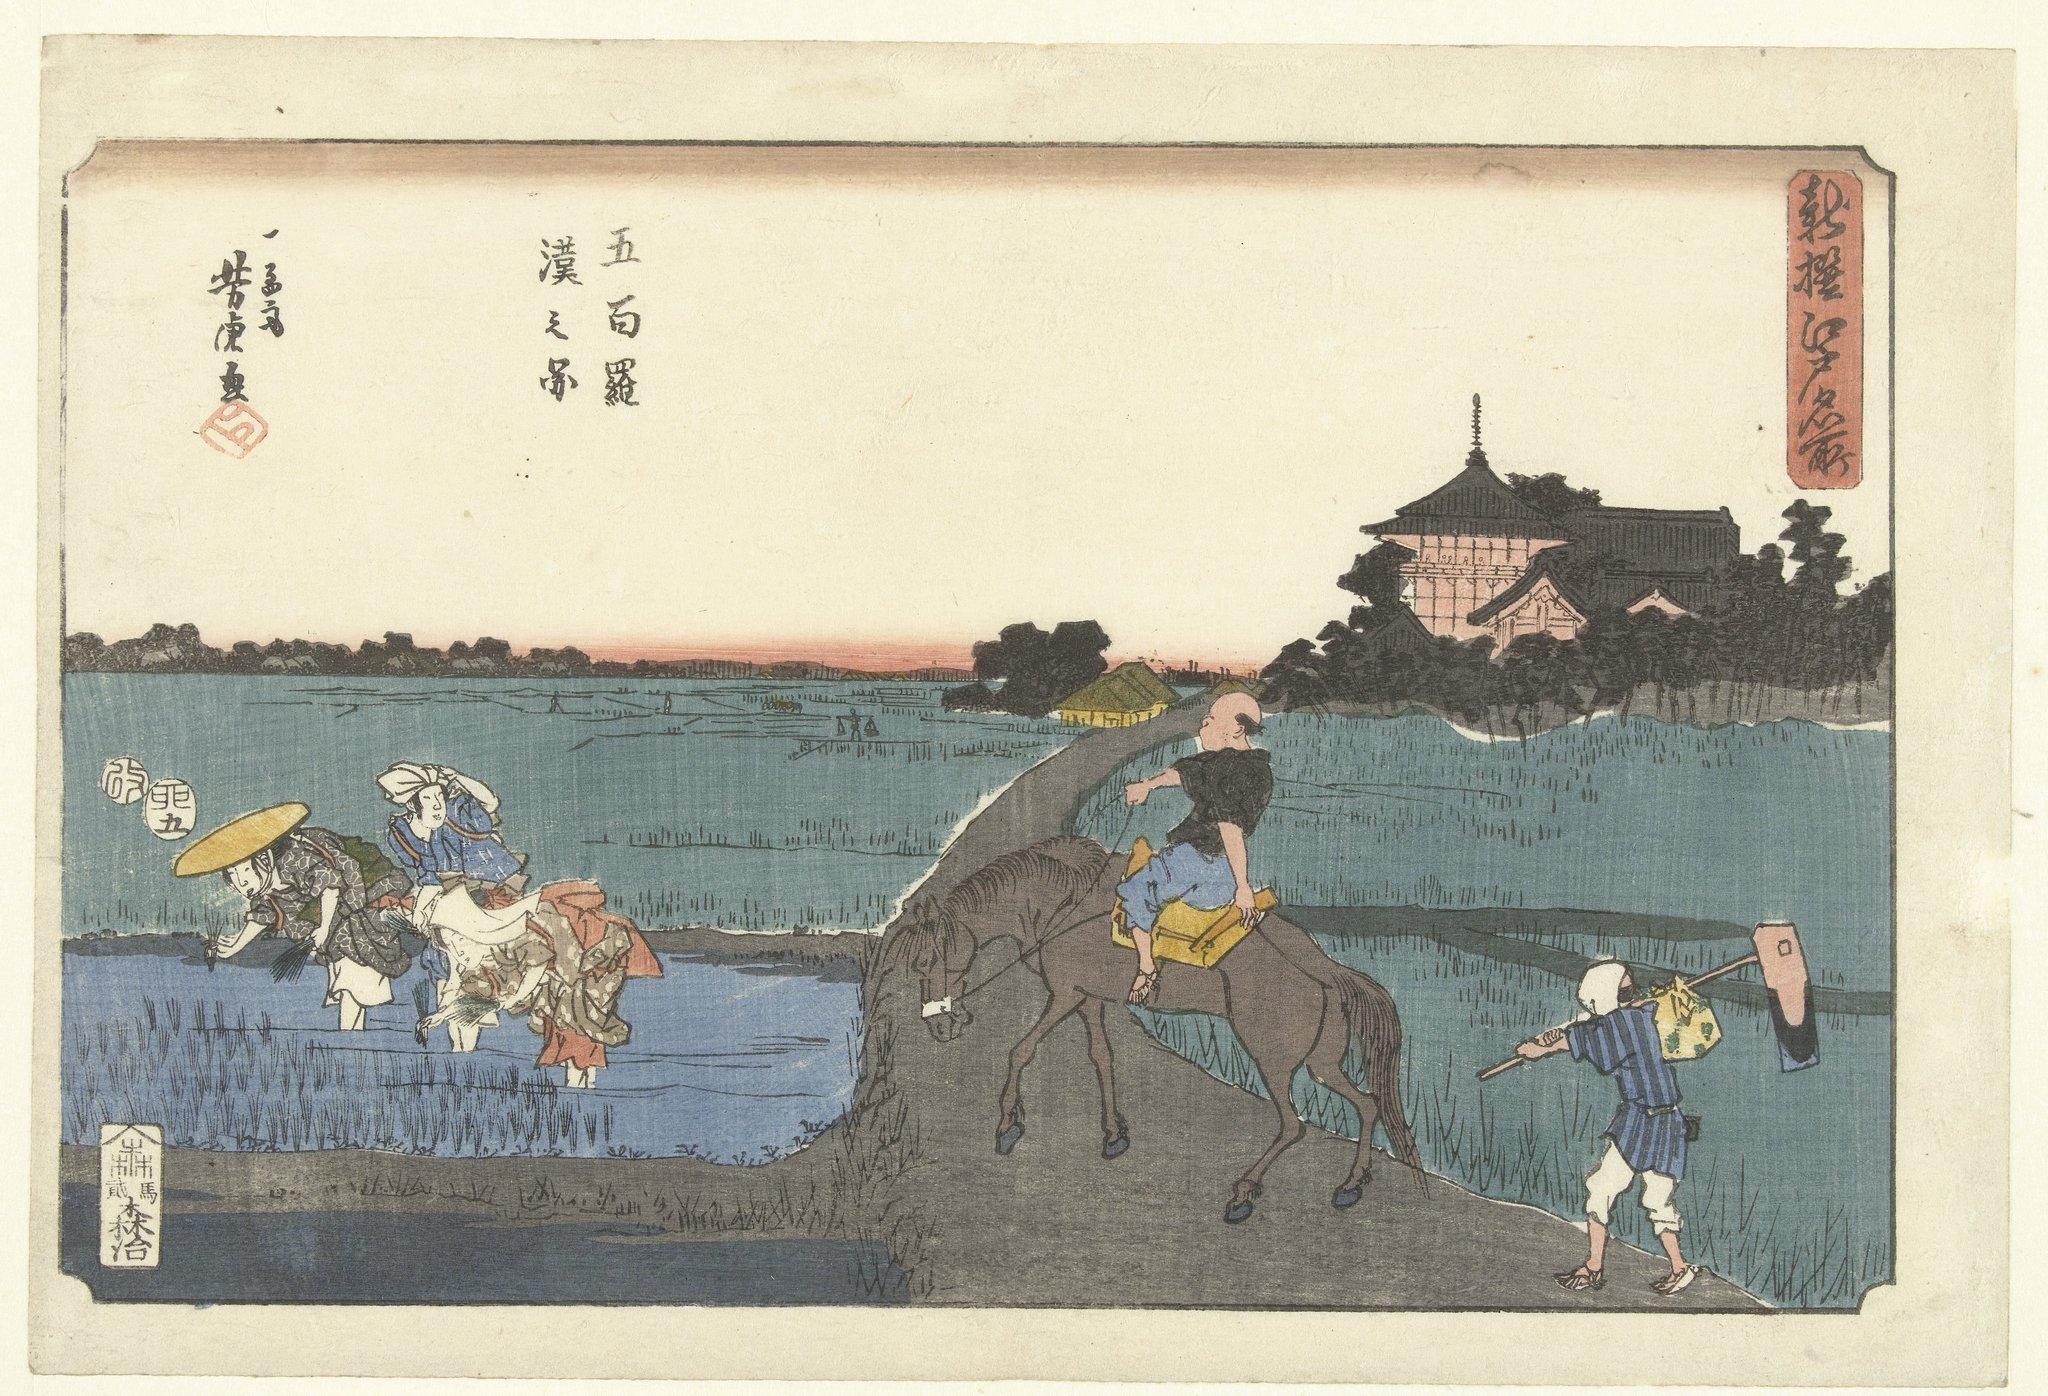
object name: print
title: Gohyaku rakan no zu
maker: utagawa yoshitora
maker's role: print maker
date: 1855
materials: paper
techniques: woodcut, nishiki e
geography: japan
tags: riding a horse, ass, or mule; rider, horseman, soil cultivation, sawahs, rice paddies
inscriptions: date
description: Rijstvelden met de Gohyaku rakan tempel op de achtergrond; op de voorgrond drie rijst plantende vrouwen, een boer en een man te paard.